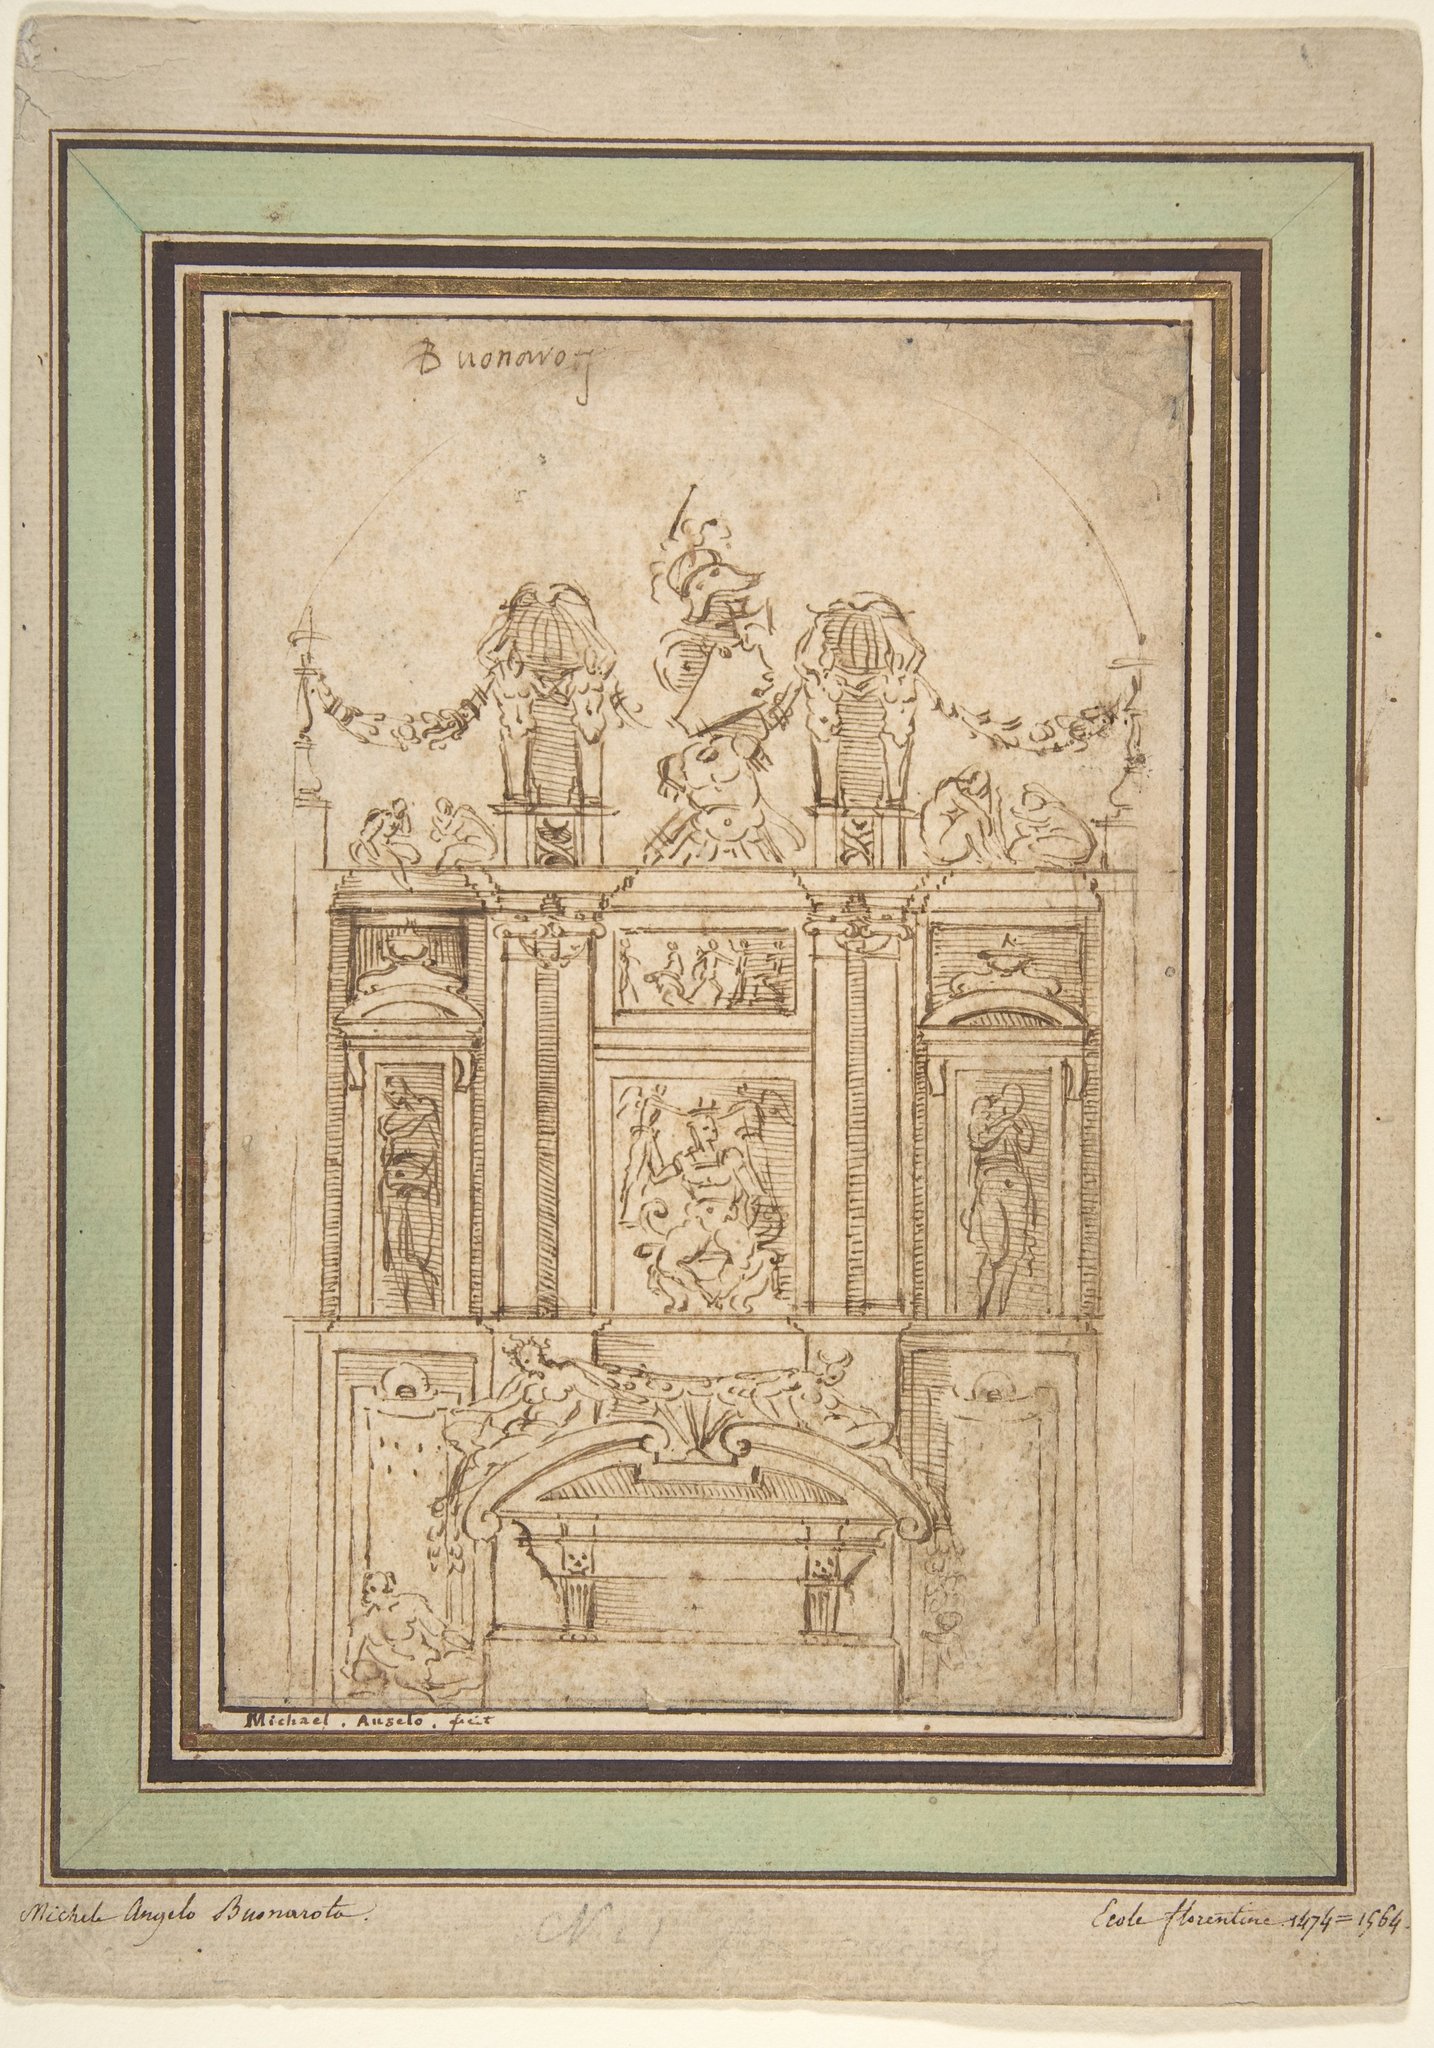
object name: drawing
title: Architectural Study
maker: michelangelo buonarroti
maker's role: artist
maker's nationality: italian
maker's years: 1475-1564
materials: ink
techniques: pen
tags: architecture,female nudes